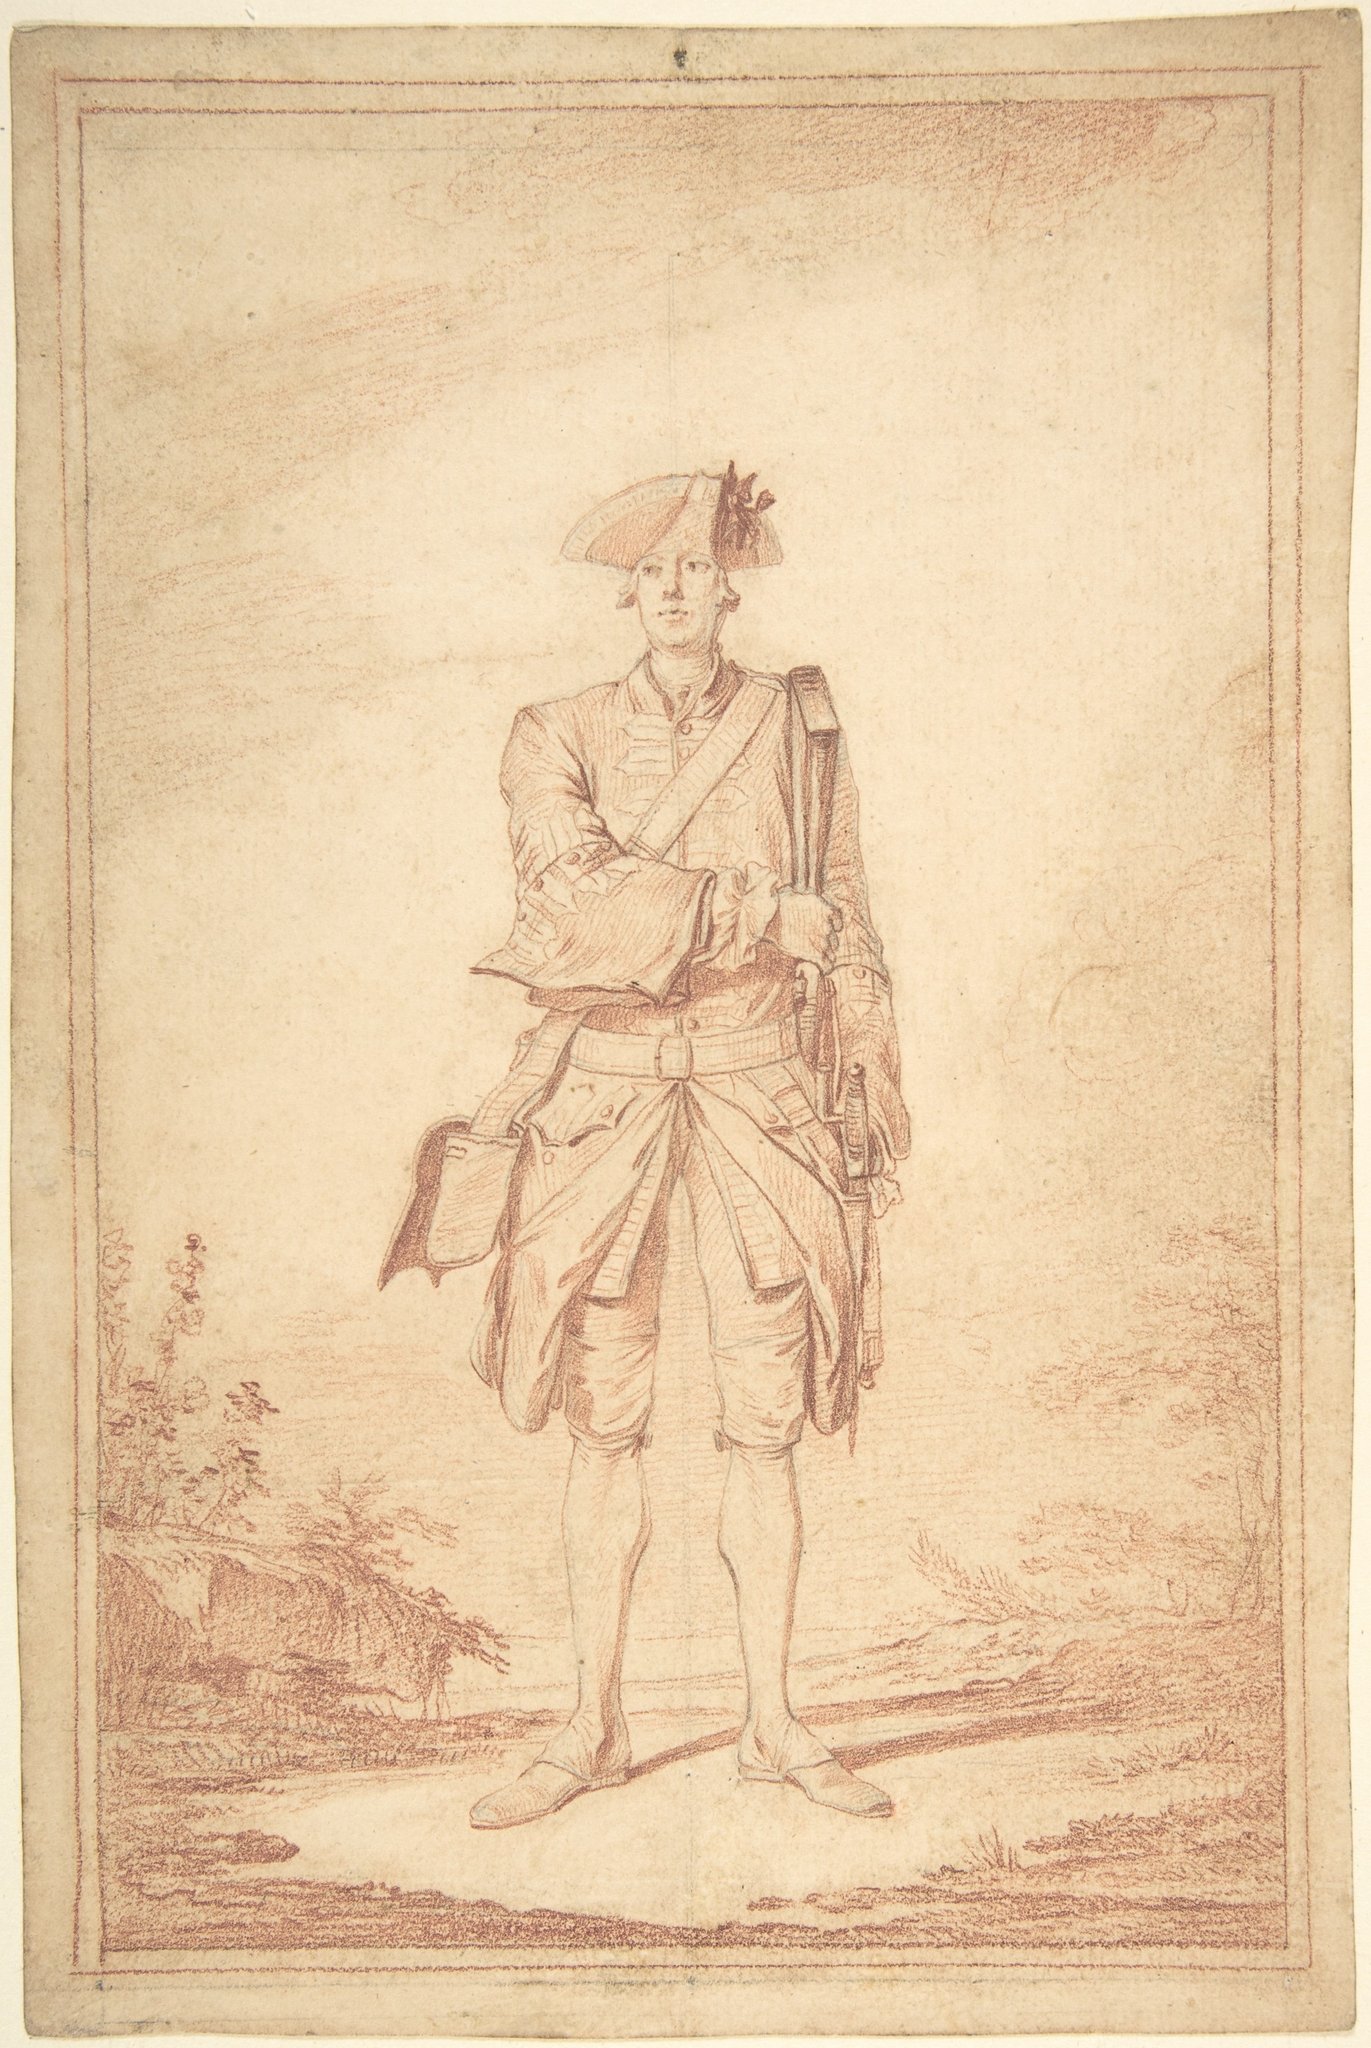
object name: drawing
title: Standing Soldier: Garde Française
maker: charles dominique joseph eisen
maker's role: artist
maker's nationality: french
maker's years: 1720-1778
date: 1701-1800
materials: chalk, graphite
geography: france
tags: soldiers